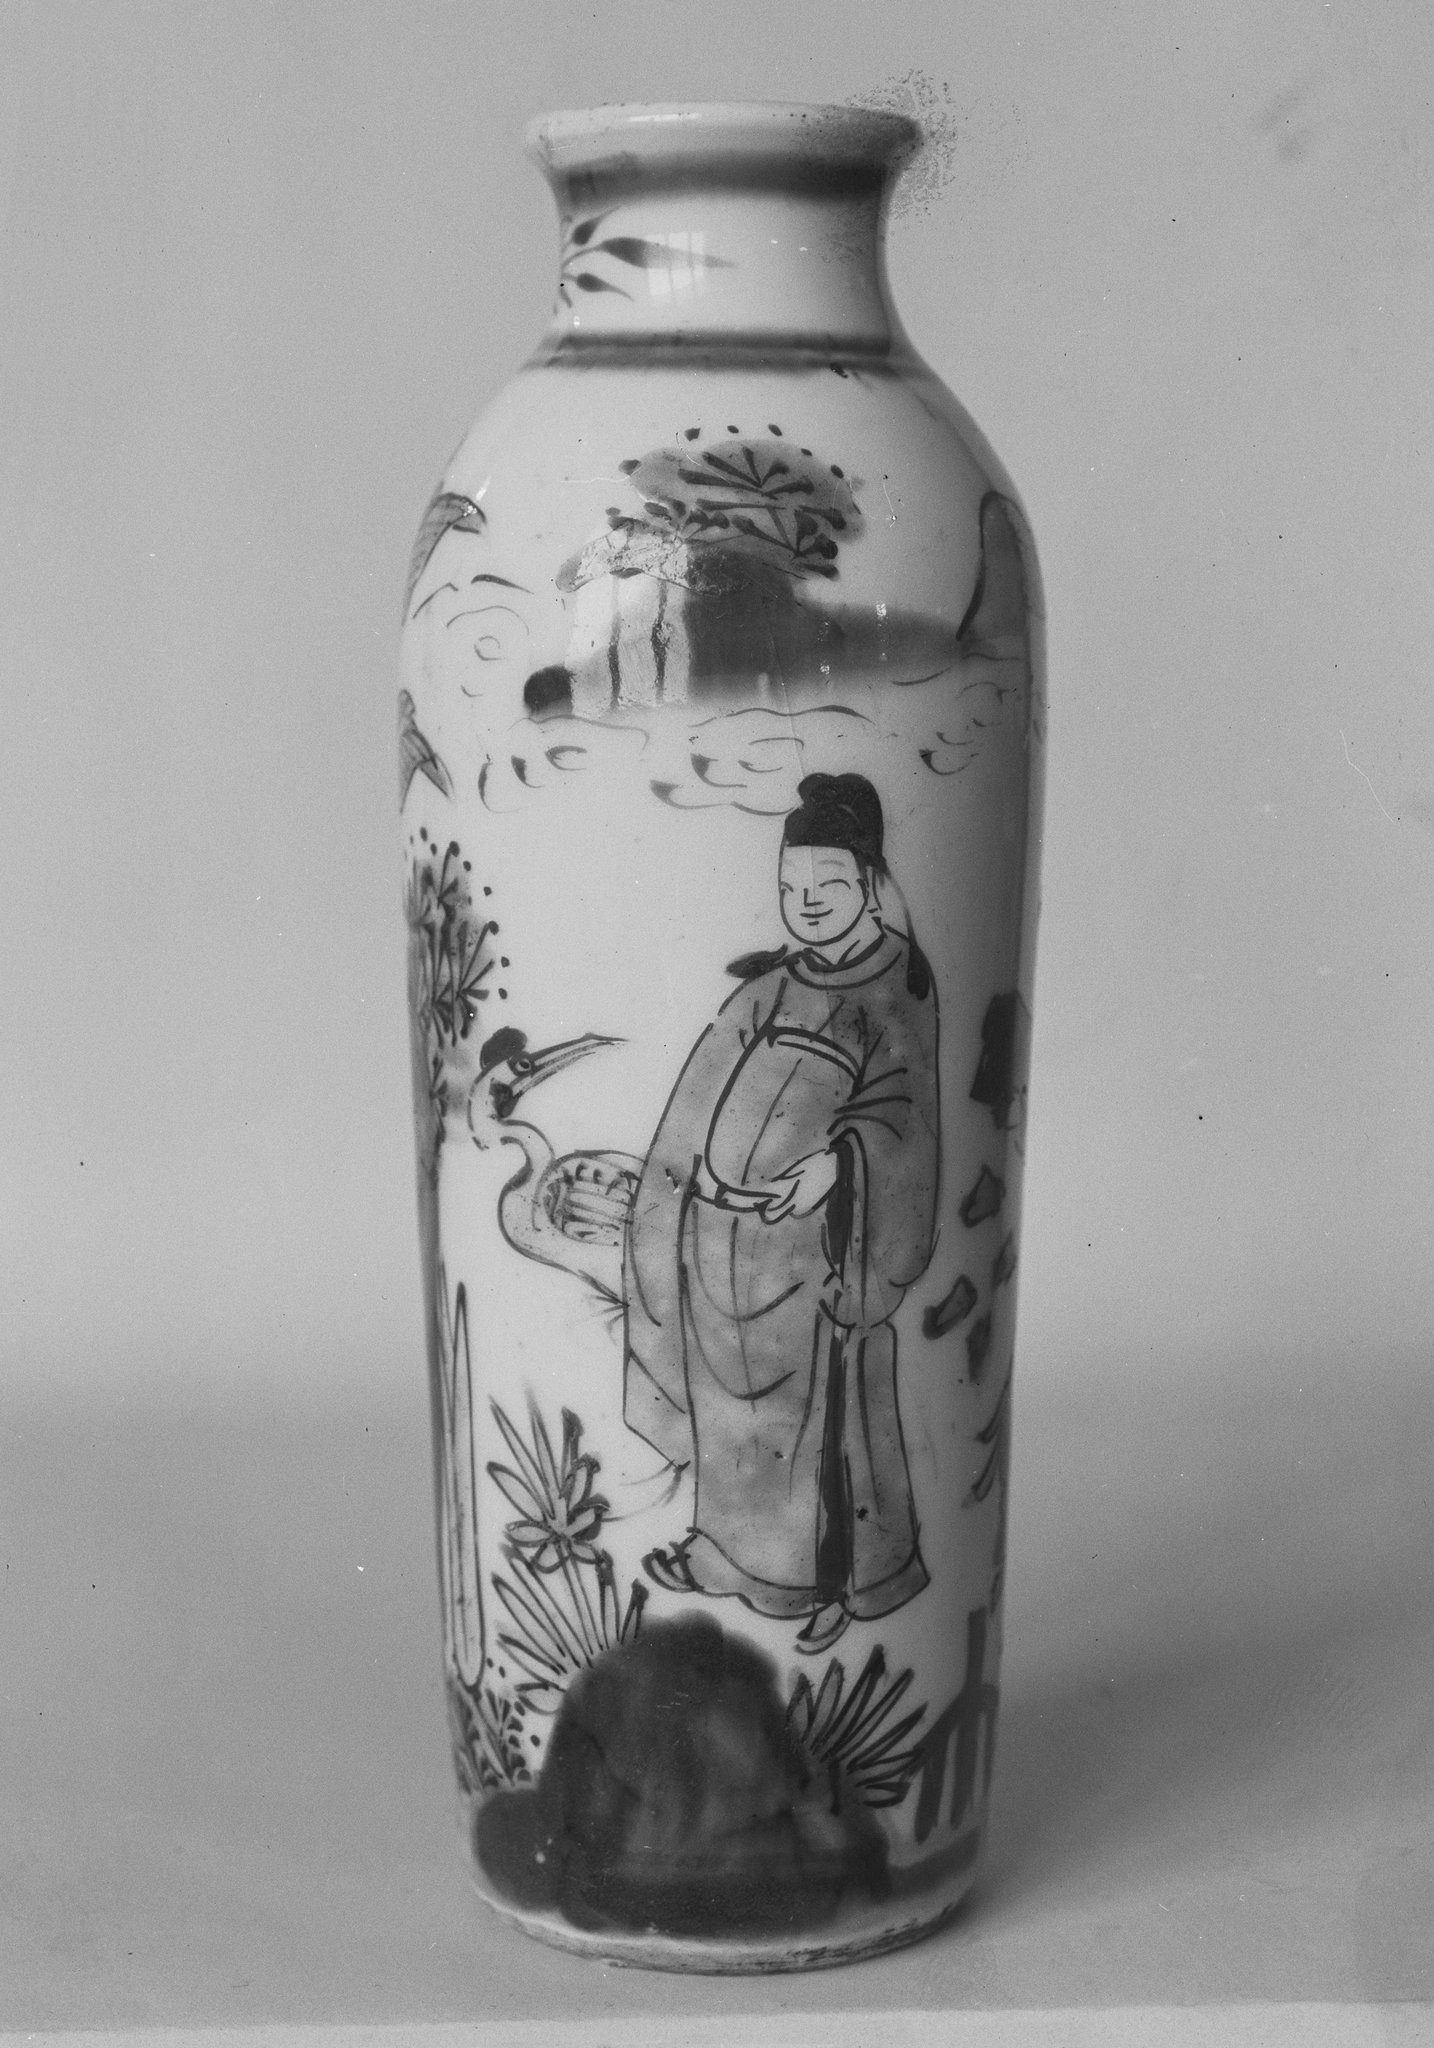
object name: vase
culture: chinese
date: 1368-1644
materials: porcelain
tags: human figures,birds